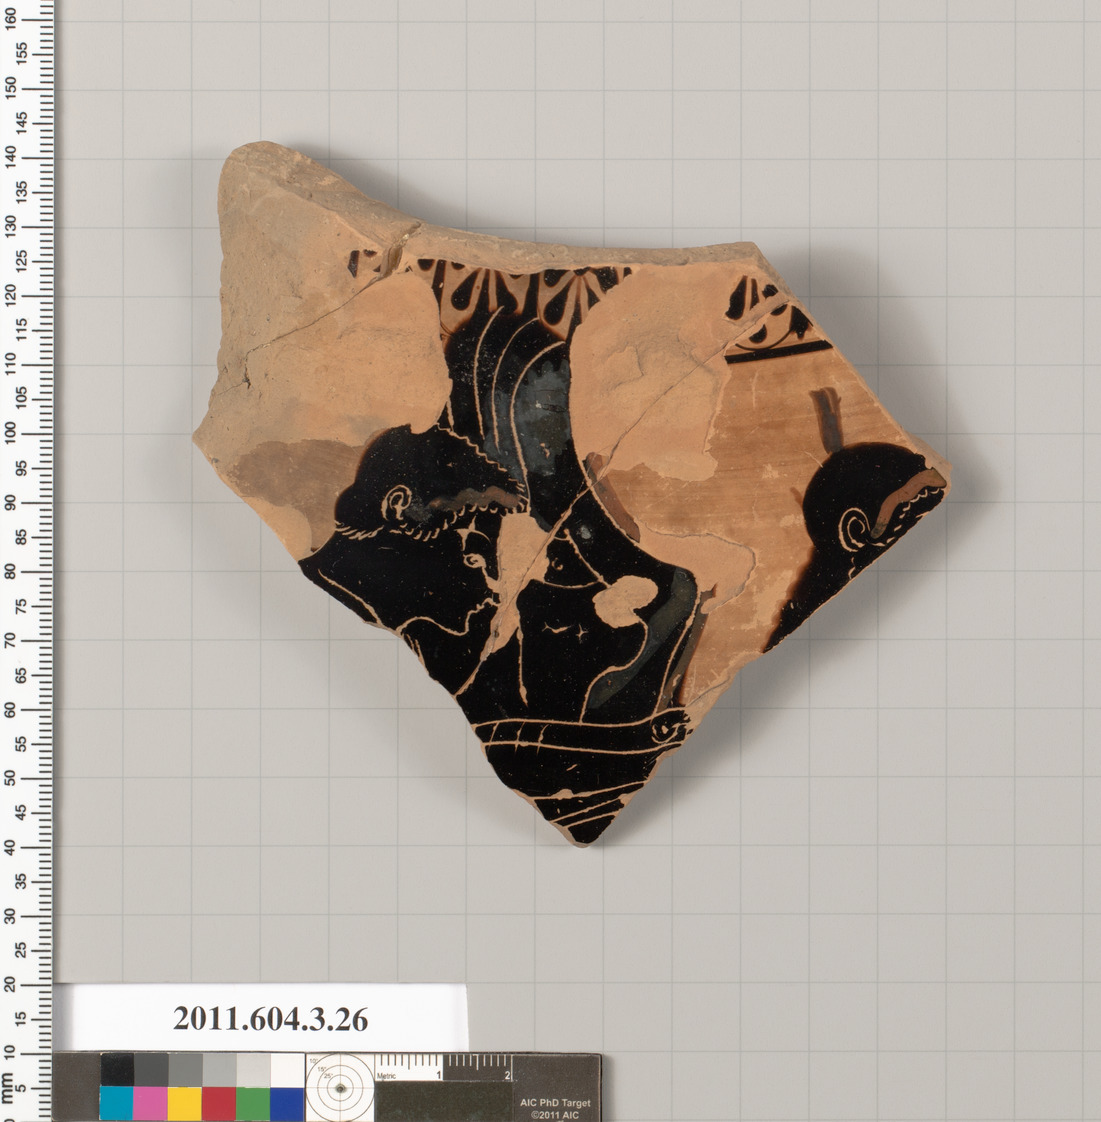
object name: amphora fragment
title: Terracotta fragment of an amphora (jar)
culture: greek, attic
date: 530-520 BCE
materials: terracotta